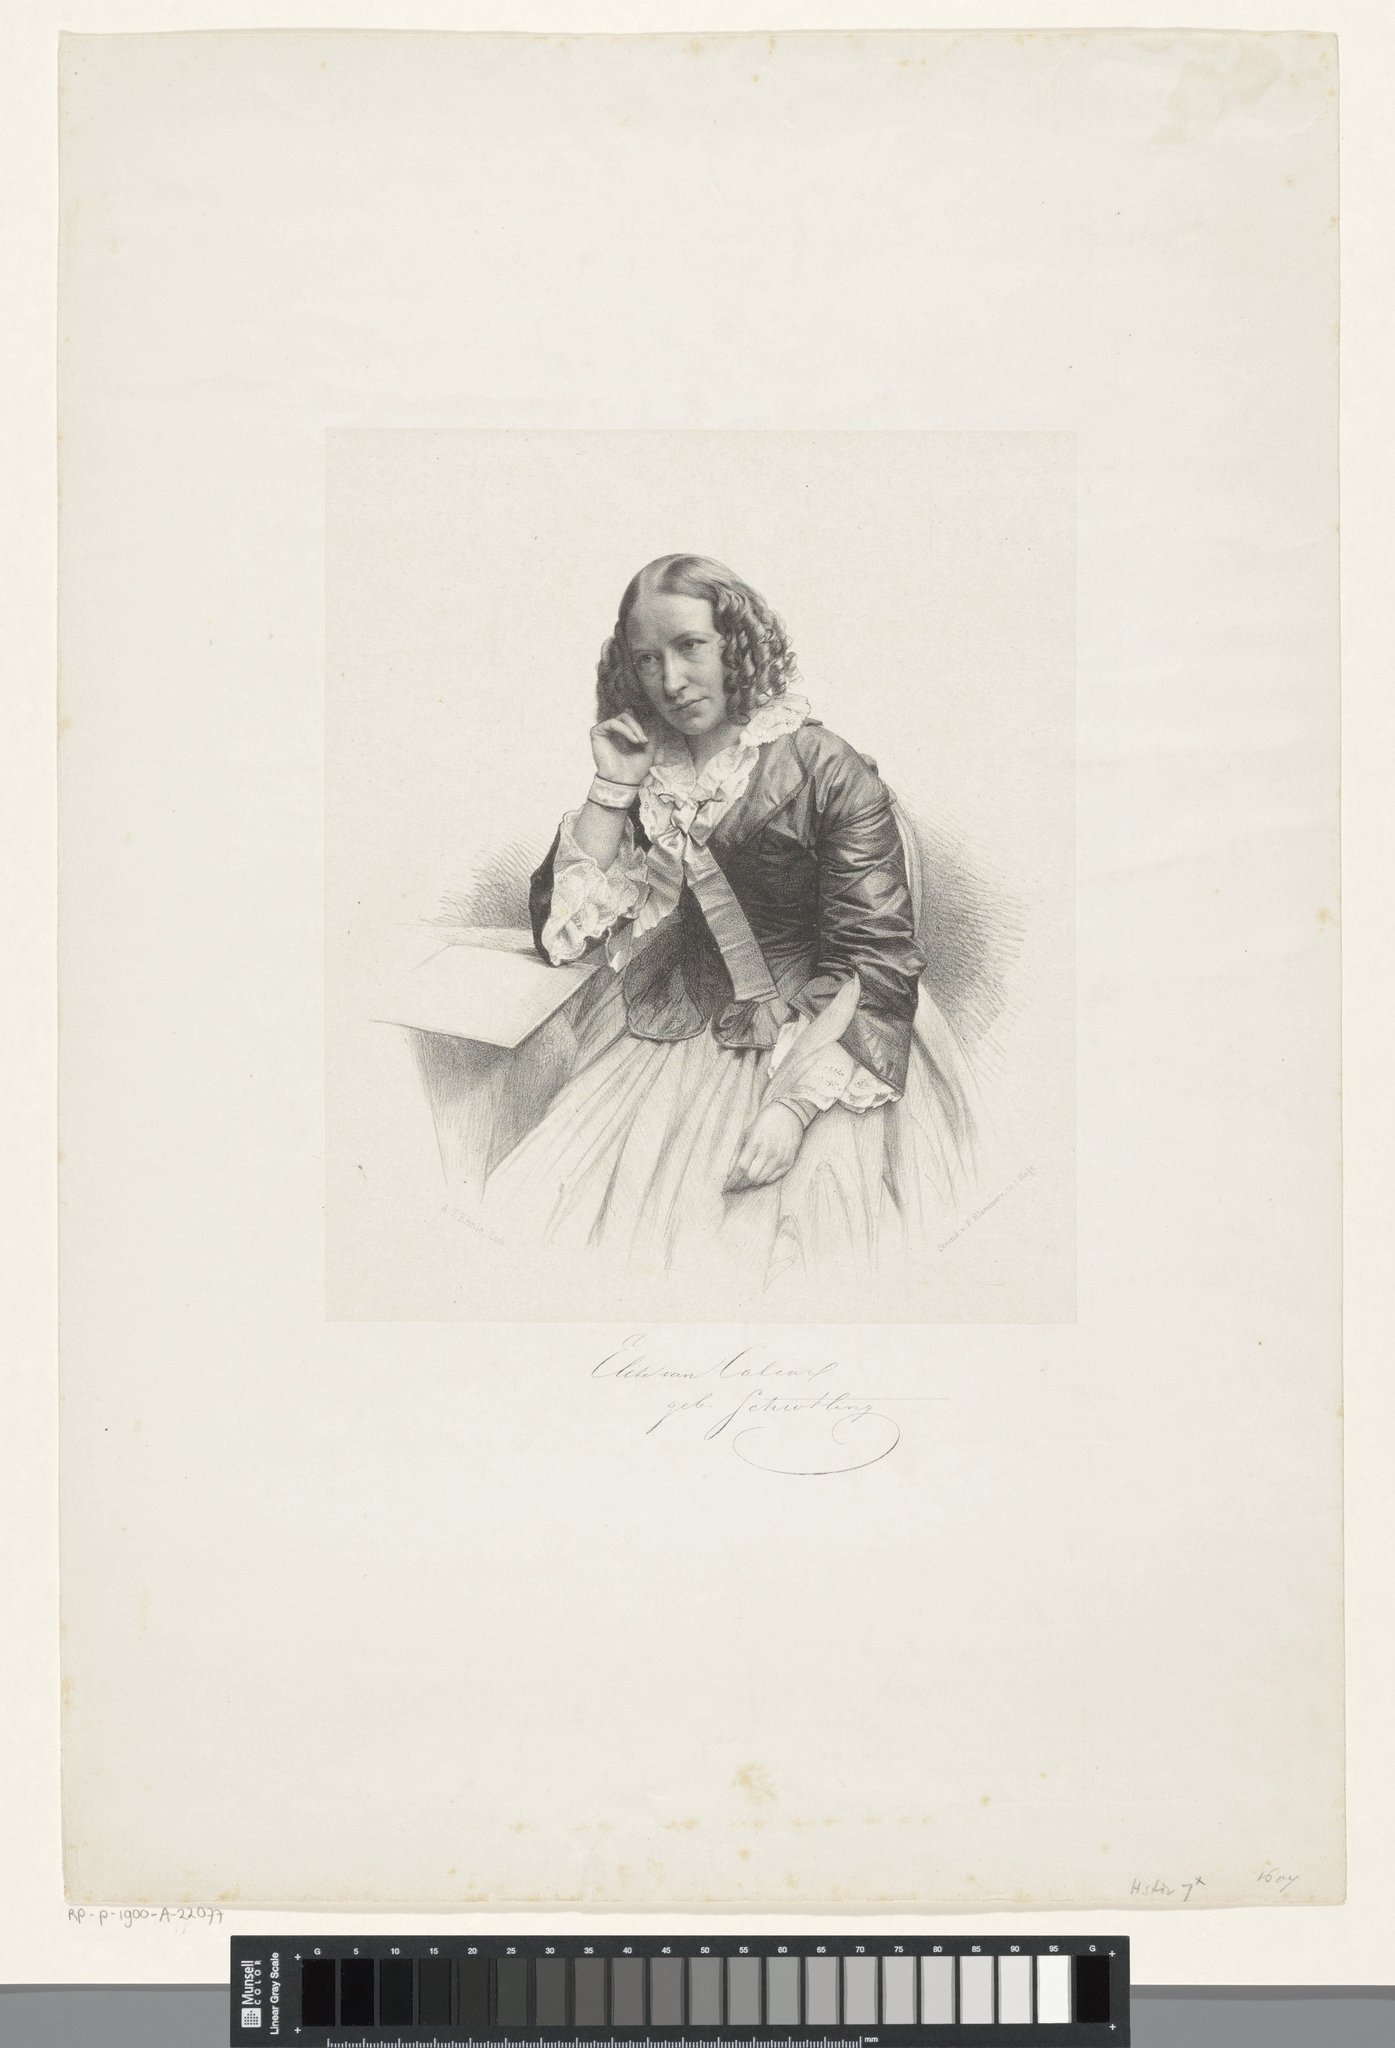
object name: print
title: Portret van Elise van Calcar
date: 1842-1887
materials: paper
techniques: lithograph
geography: the hague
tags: historical persons (+ half-length portrait)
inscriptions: collector's mark: Lugt 2228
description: De geportretteerde zit naast een tafel. Met haar rechter elleboog leunt zij op een opengeslagen boek dat op tafel ligt. Het haar draagt zij in pijpenkrullen. Ze kijkt naar links. Onder het portret haar naam.